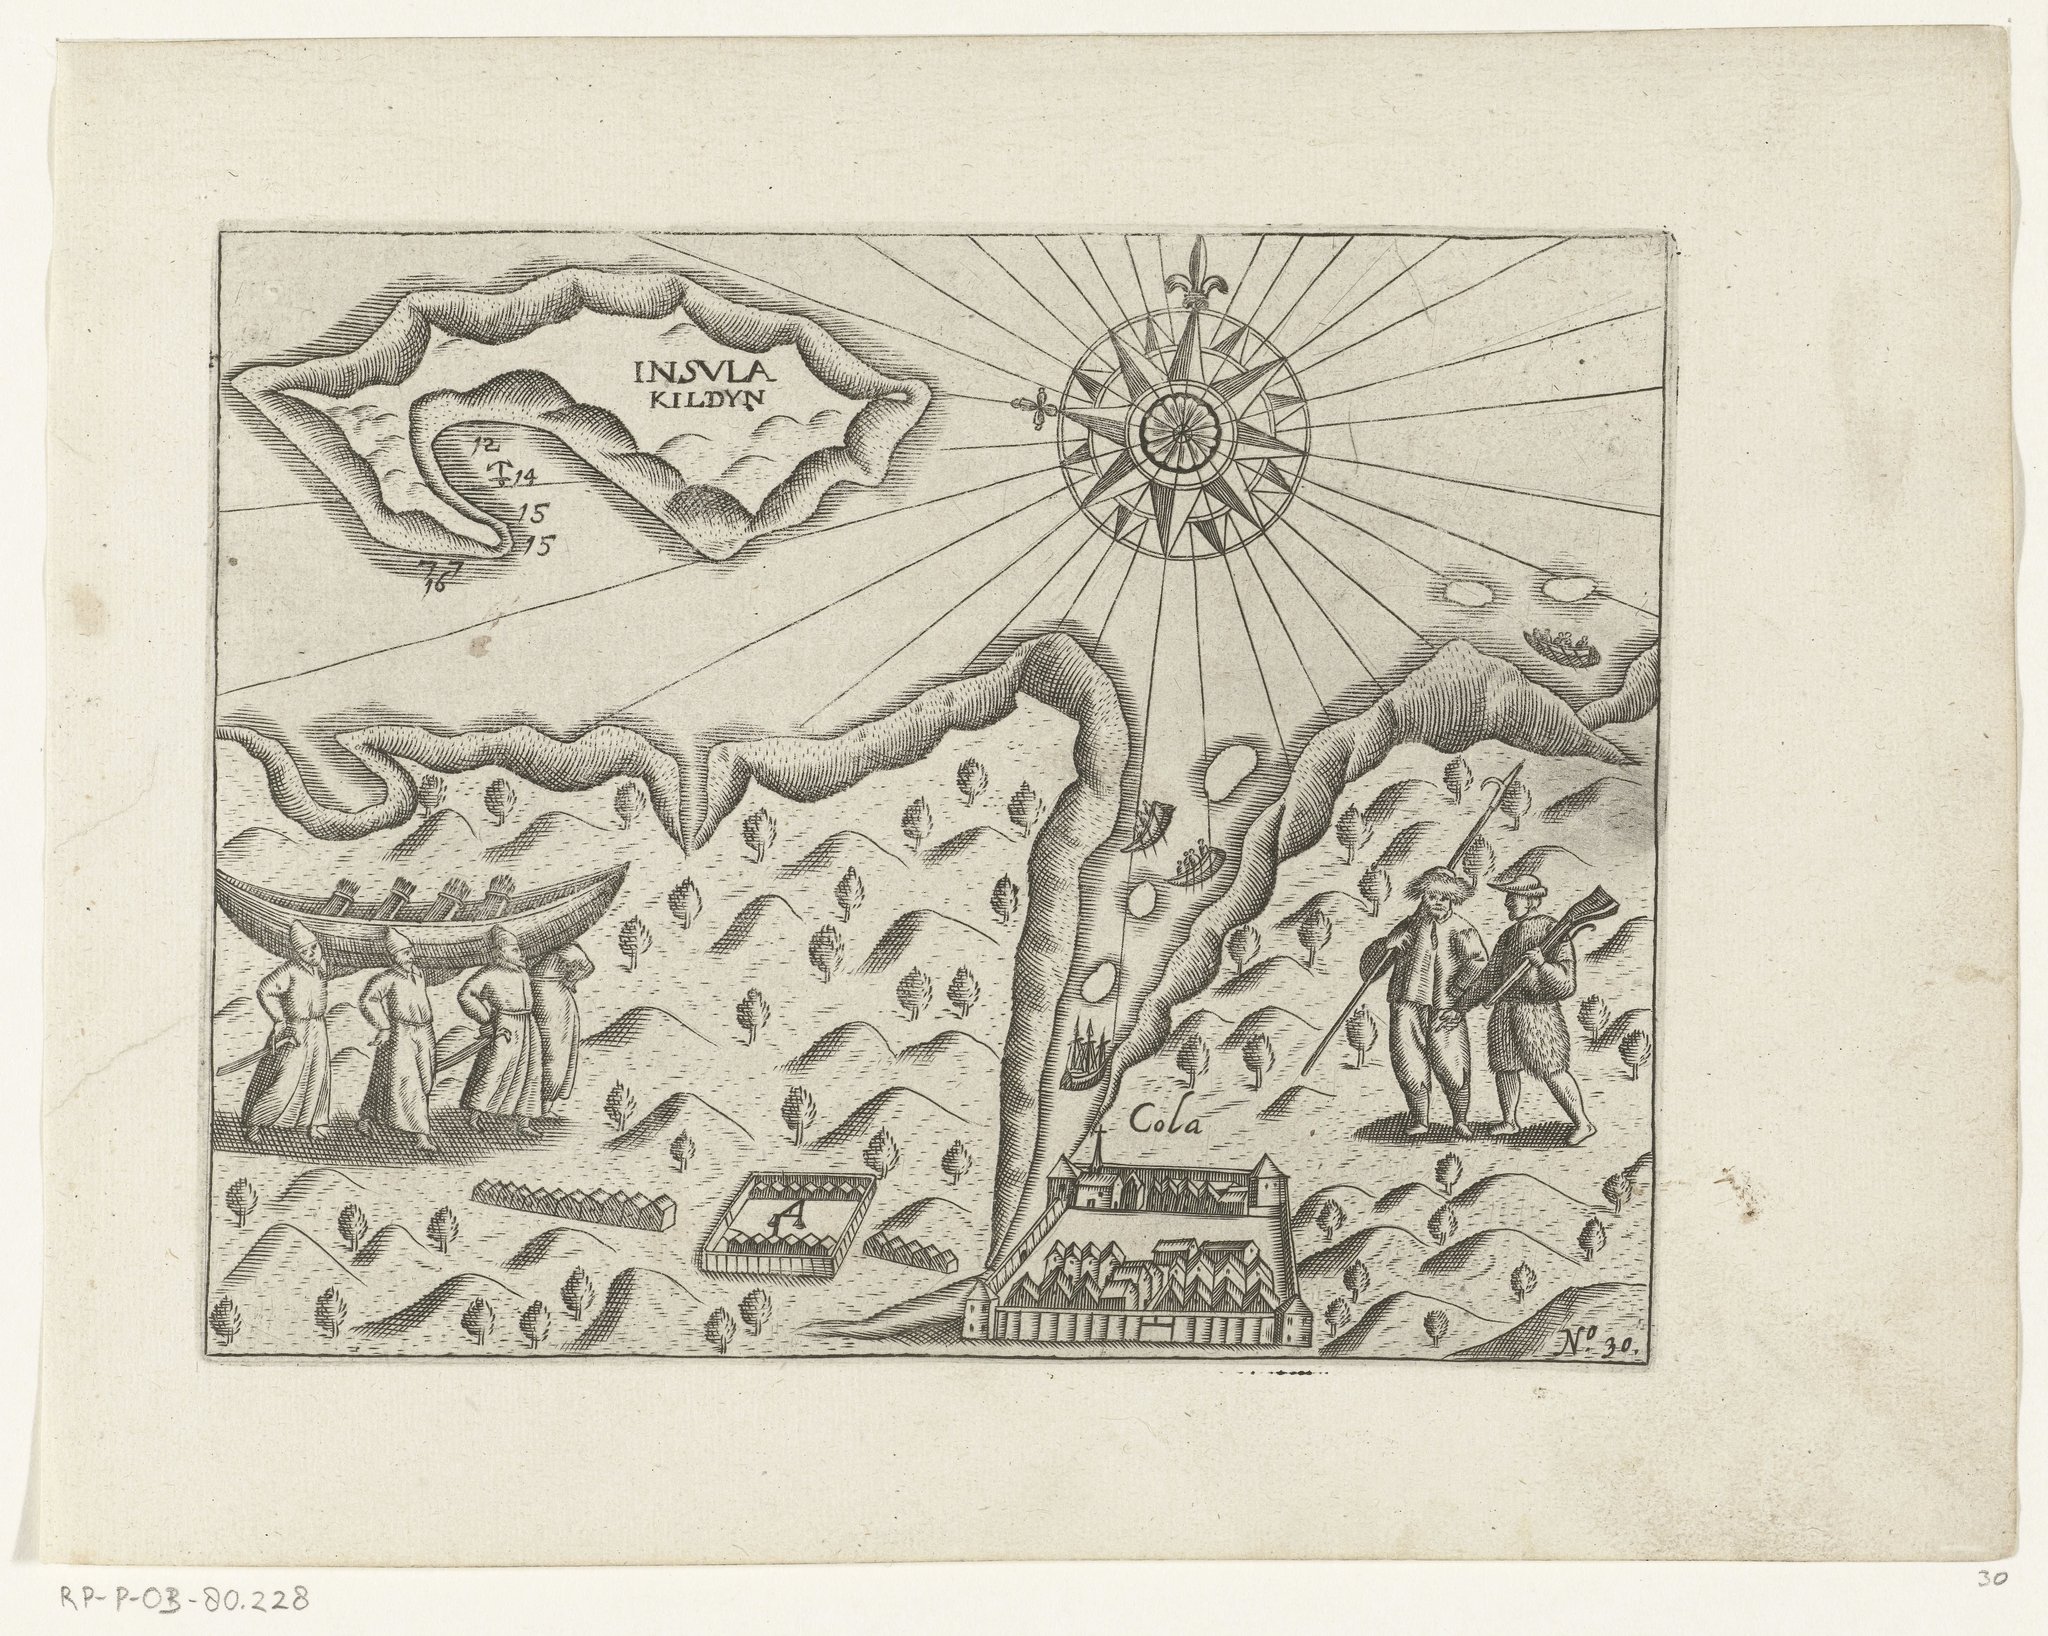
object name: map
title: Kaartje van de rivermond met het plaatsje Kola, 1597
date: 1615-1617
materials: paper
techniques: engraving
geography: northern netherlands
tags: willem barendsz., amsterdam, jacob van heemskerck, maps of separate countries or regions, landscapes in polar regions, exploration, expedition, voyage of discovery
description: Gebruikt als illustratie eerst in: G. de Veer, De waerachtige beschrijvinge vande drie seylagien, drie jaren achter mal-kanderen deur de Hollandtsche ende Zeelandtsche Schepen, by noorden Noorweghen, Moscovien ende tartarien nae de Coninckrijcken van Catthay ende China ghedaene, [Michiel Colijn, Amsterdam 1617]. Later gebruikt in: Kort verhael van d'eerste Schipvaerd der Hollandsche ende Zeeusche Schepen by noorden Noorwegen, Moscovien ende Tartarien om, nae de Coningrijcken van Cathay ende China, getogen uyt het Journael van Gerrit de Veer. Opgenomen in: I. Commelin, Begin ende voortgangh, van de Vereenighde Nederlantsche Geoctroyeerde Oost-Indische Compagnie, J. Janssonius, Amsterdam 1646. Genummerd: No. 30.